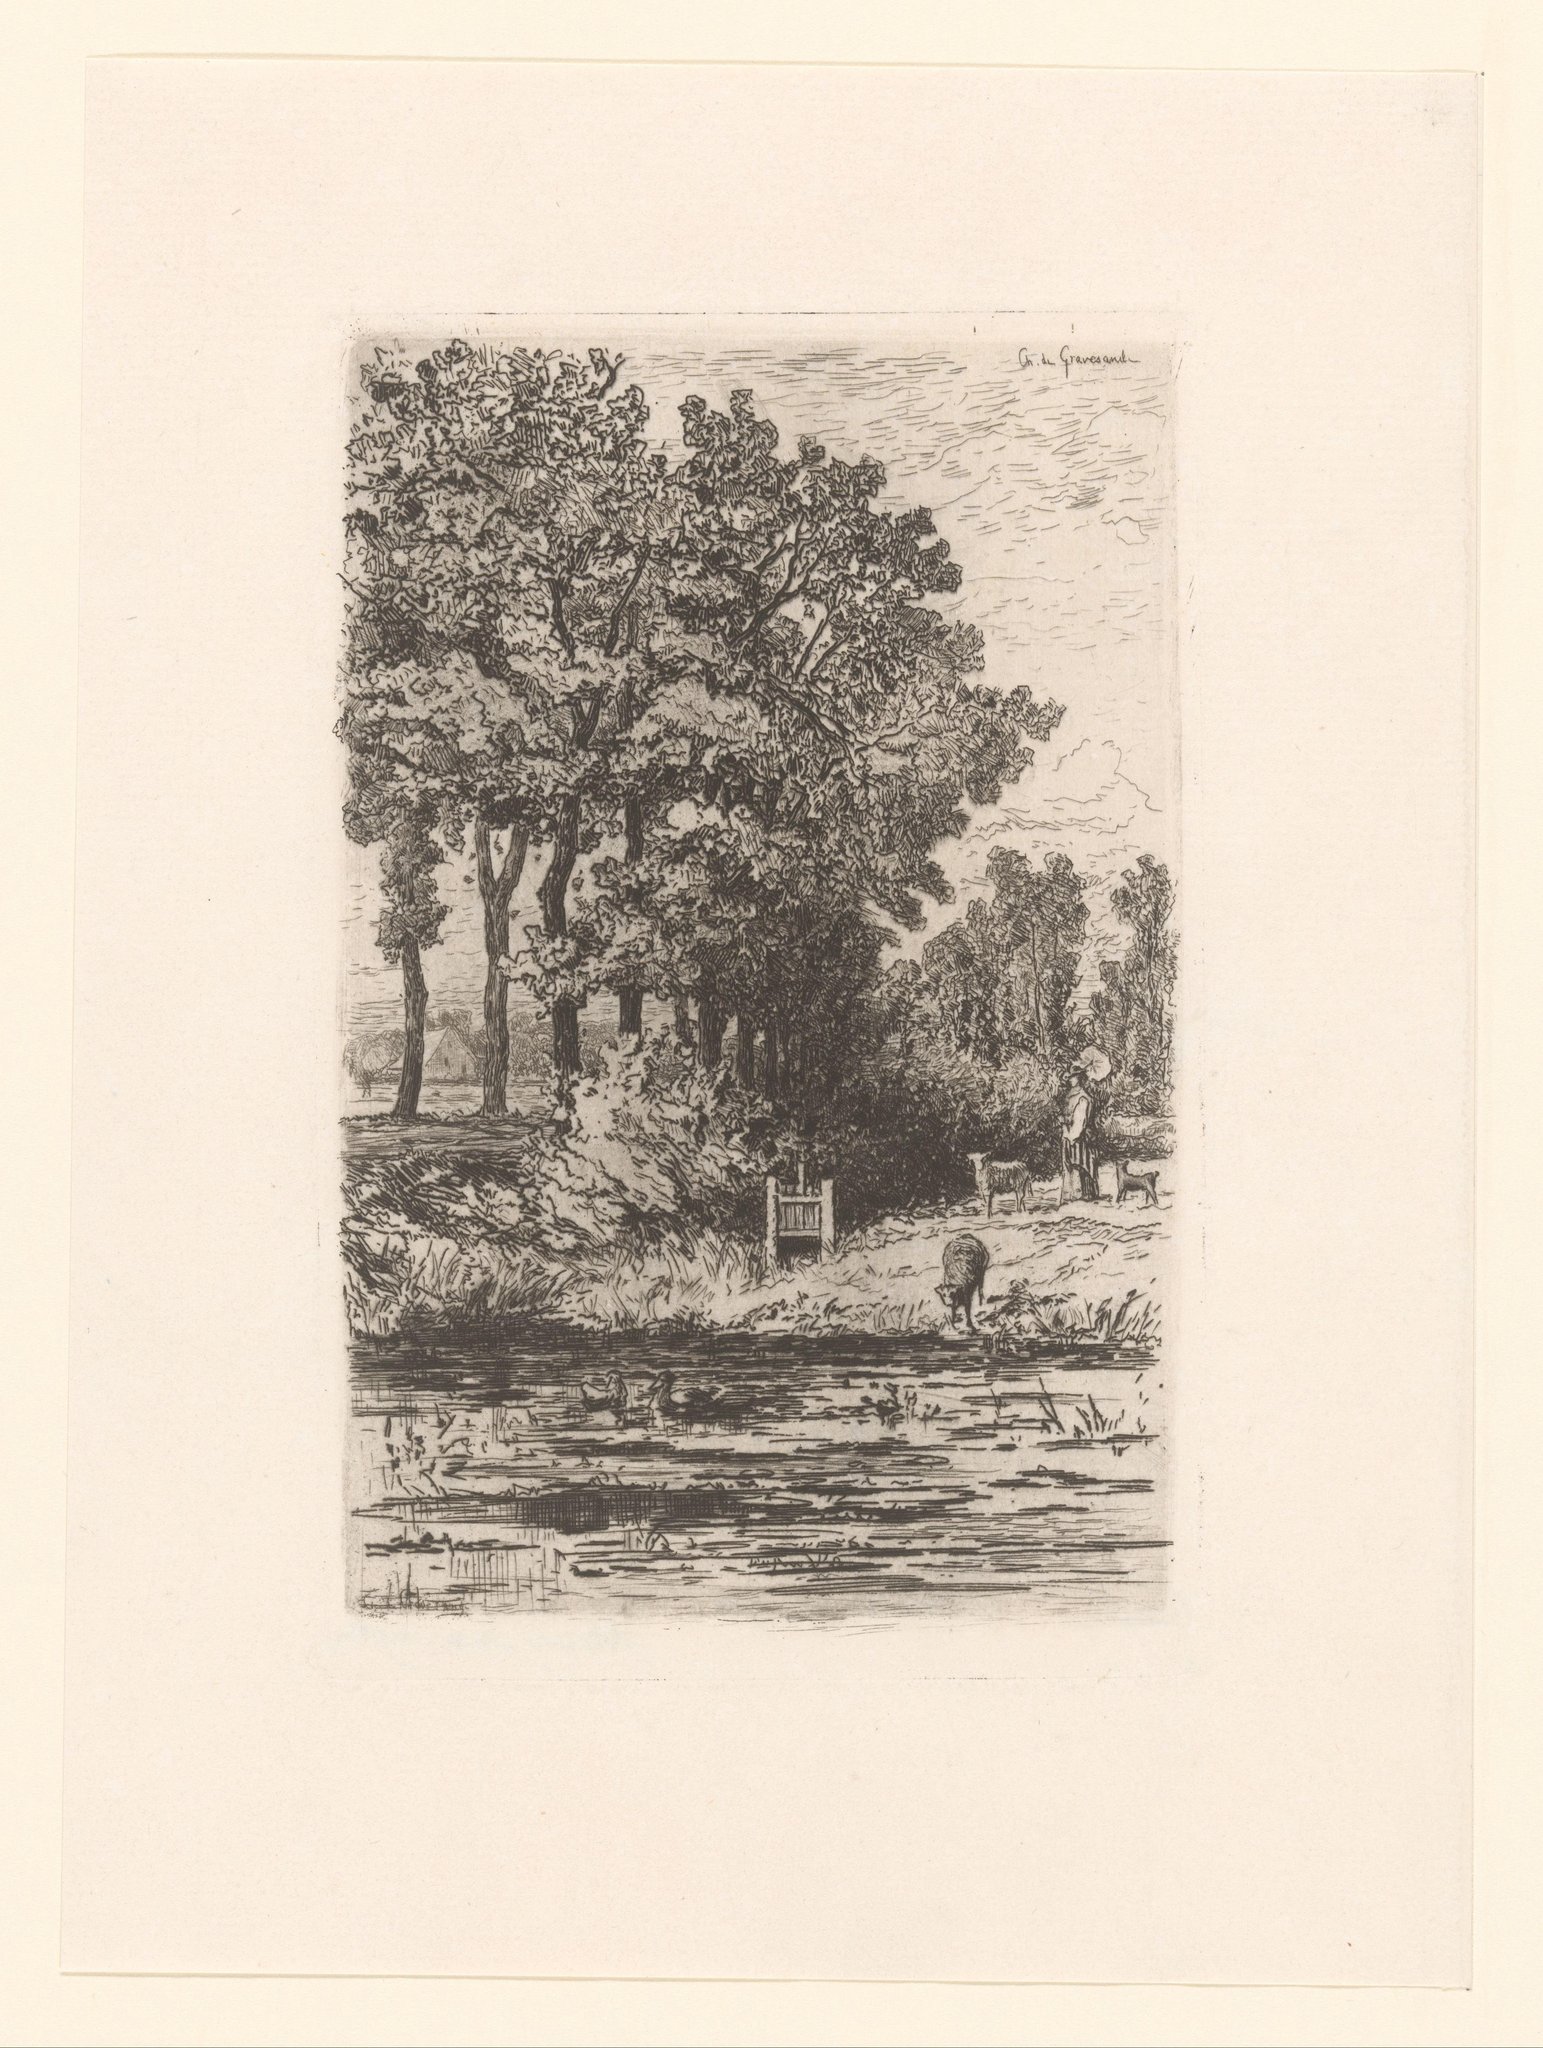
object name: print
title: Landschap met eiken en water bij Noord Deurningen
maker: carel nicolaas storm van s-gravesande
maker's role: draughtsman, print maker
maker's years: 1841-1924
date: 1851-1910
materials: paper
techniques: etching, intaglio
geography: netherlands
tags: trees: oak, brook, sheep, meadow, pasture (+ landscape with figures, staffage)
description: Rechts staat een vrouw met een parasol in een weiland tussen de schapen.